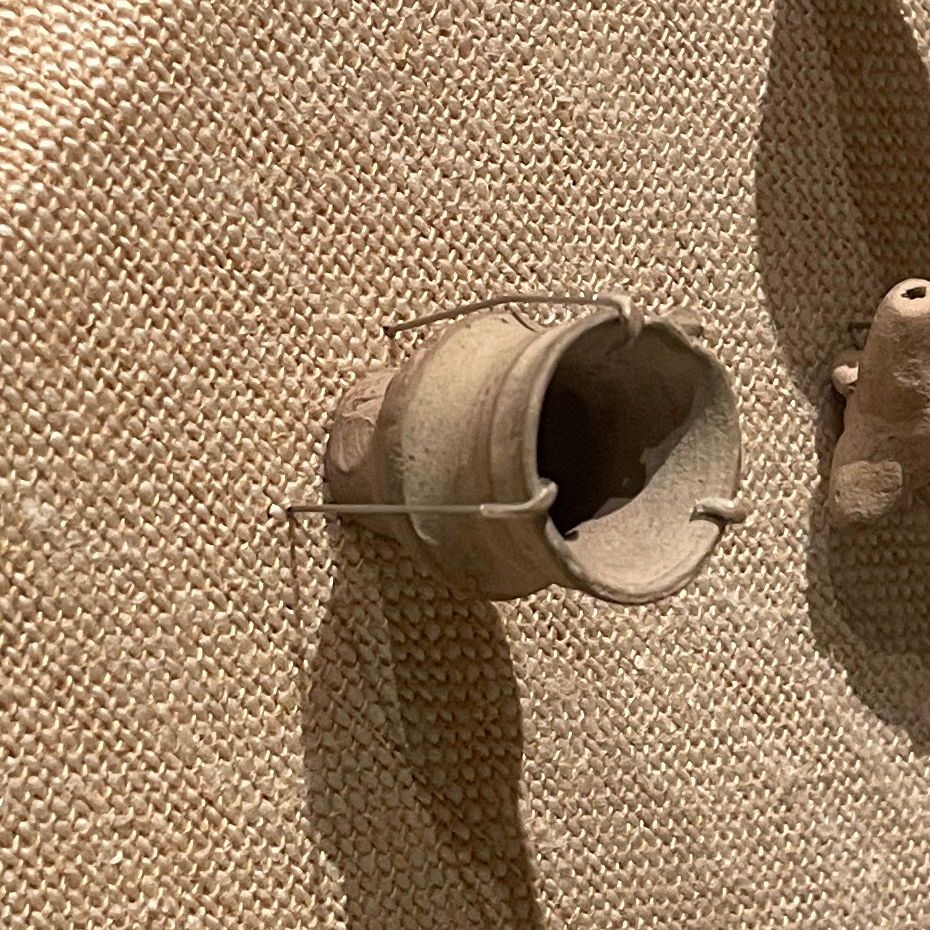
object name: jar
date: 801-900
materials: earthenware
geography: iran